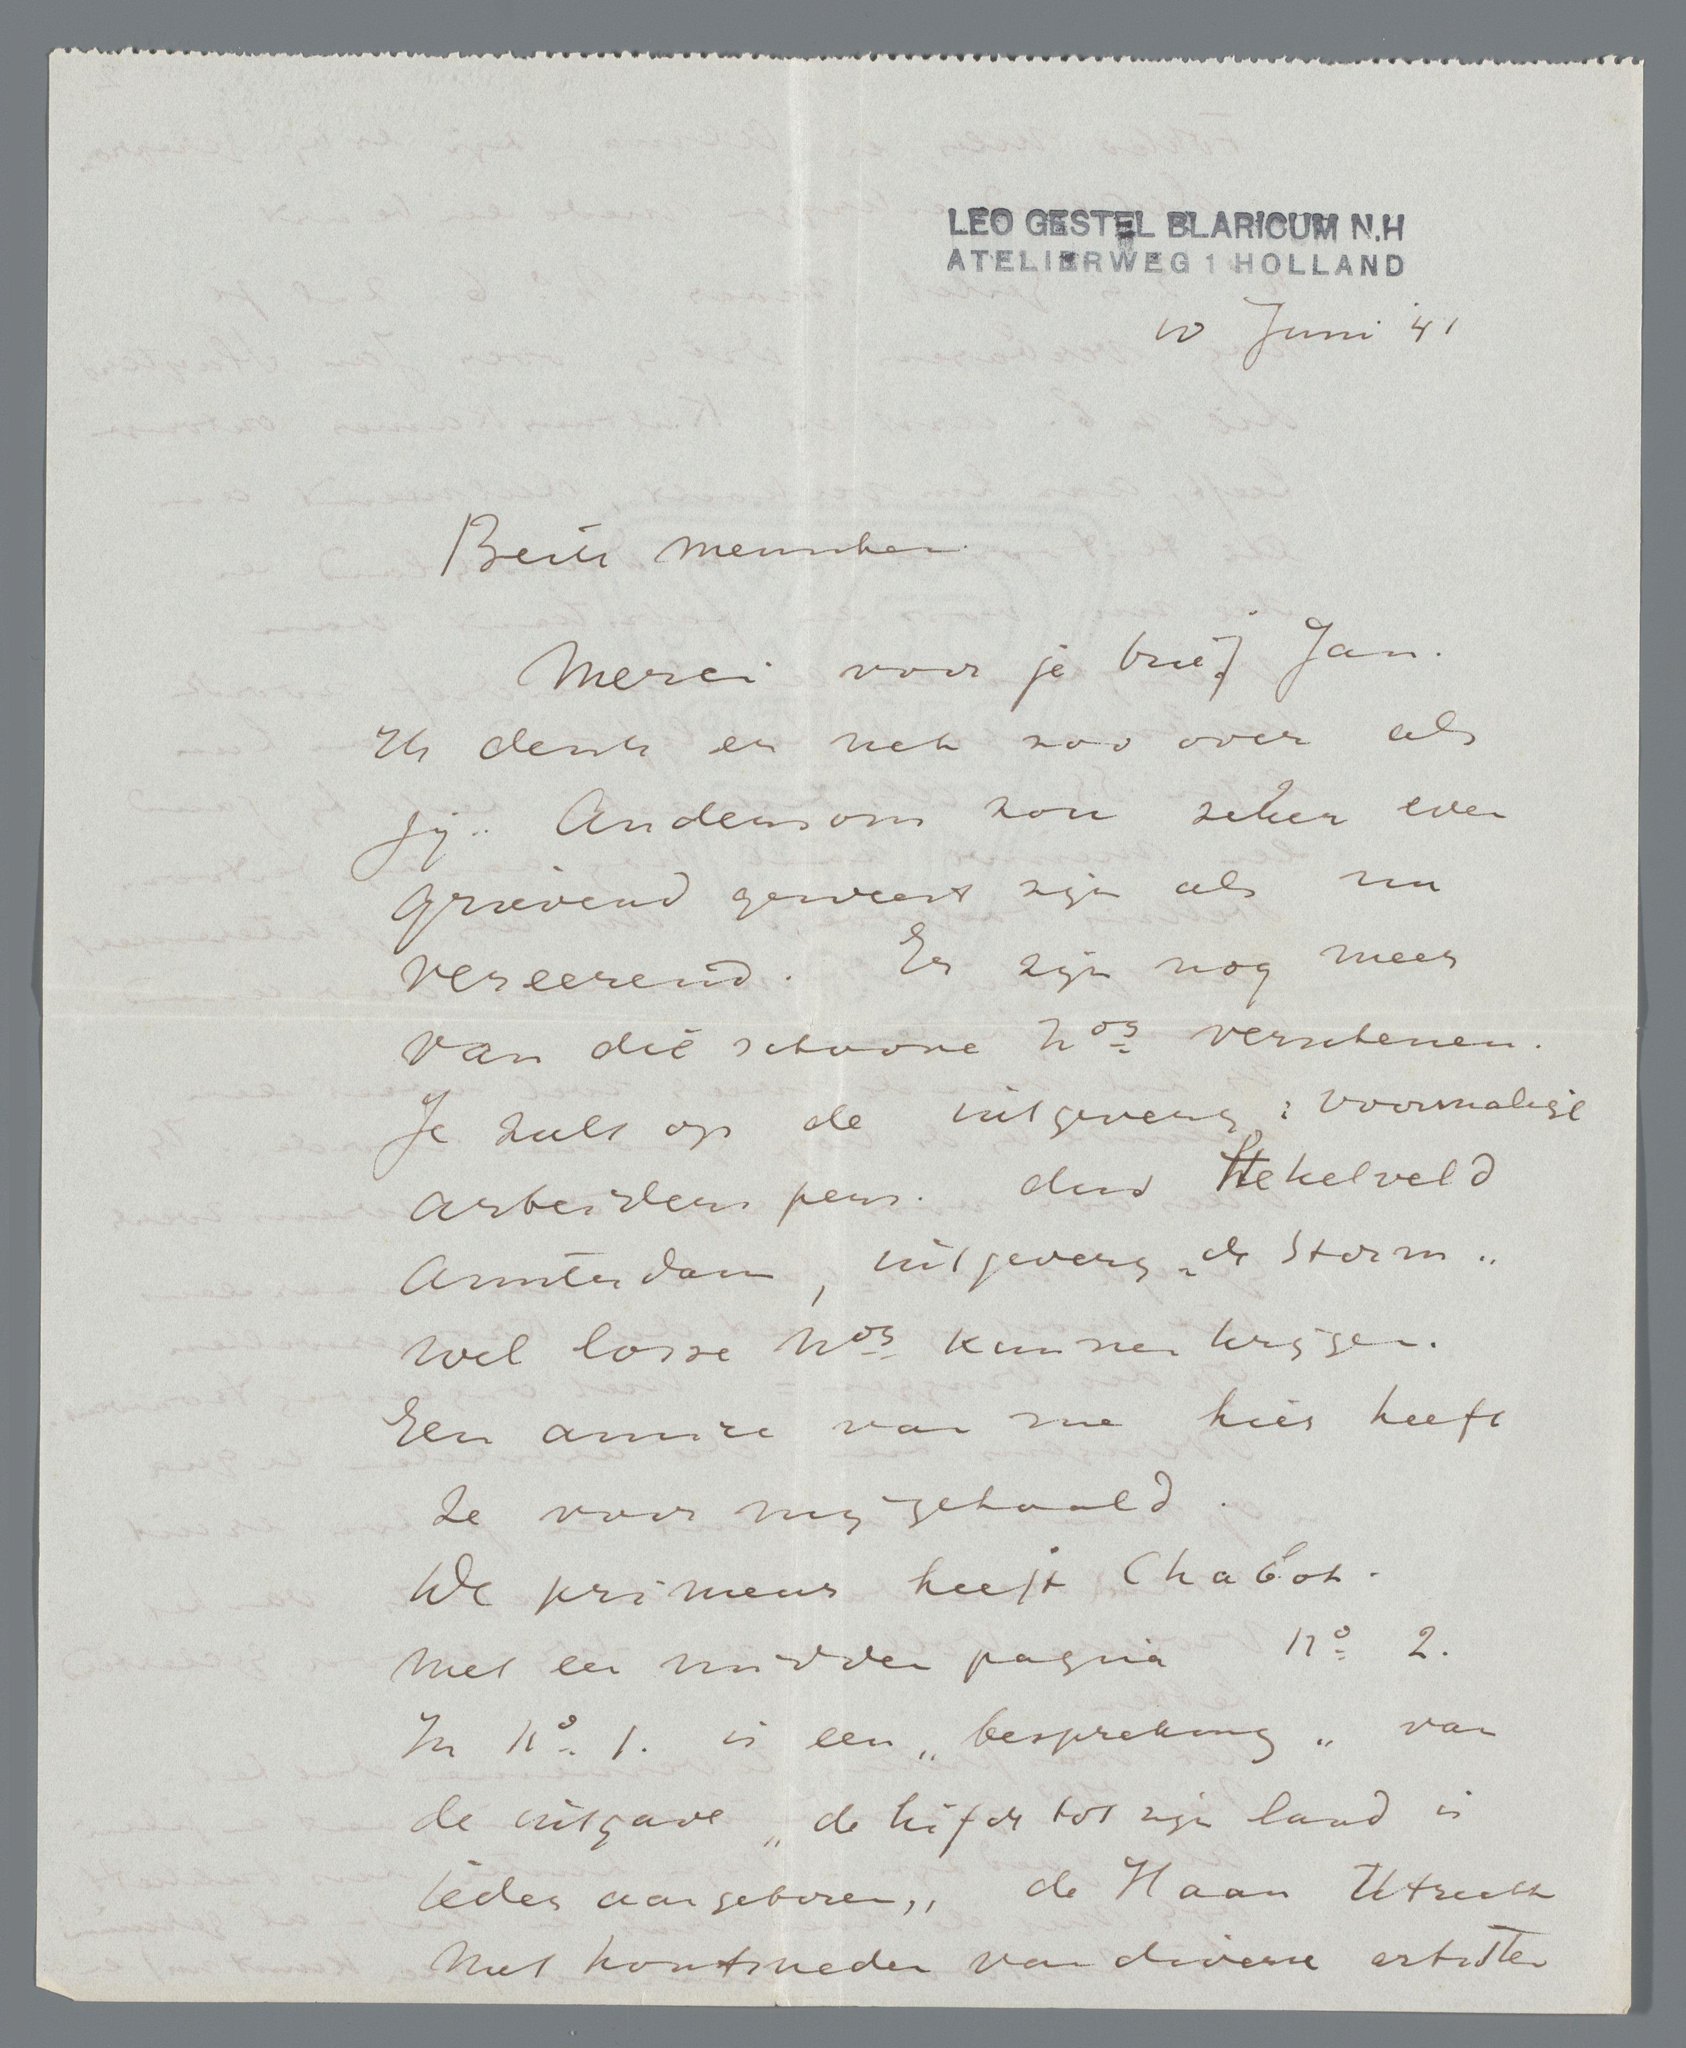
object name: letter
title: Brief aan Jan Ponstijn en Henriëtte Johanna Petronella van Hilten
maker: leo gestel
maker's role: draughtsman, print maker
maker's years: 1881-1941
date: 1941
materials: ink, paper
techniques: pen, writing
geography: blaricum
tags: henriëtte johanna petronella ponstijn-van hilten, amsterdam, painter, print maker, draughtsman, johan jacob voskuil, rotterdam, hendrik chabot, sculptor, hildo krop, batavia, fokko mees, jan petrus ponstijn, den bosch, jan sluijters, matthieu wiegman, the arts; artists, political propaganda, weekly, monthly, magazine, etc.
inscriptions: workshop stamp: ‘LEO GESTEL BLARICUM N.H./ ATELIERWEG 1 HOLLAND’